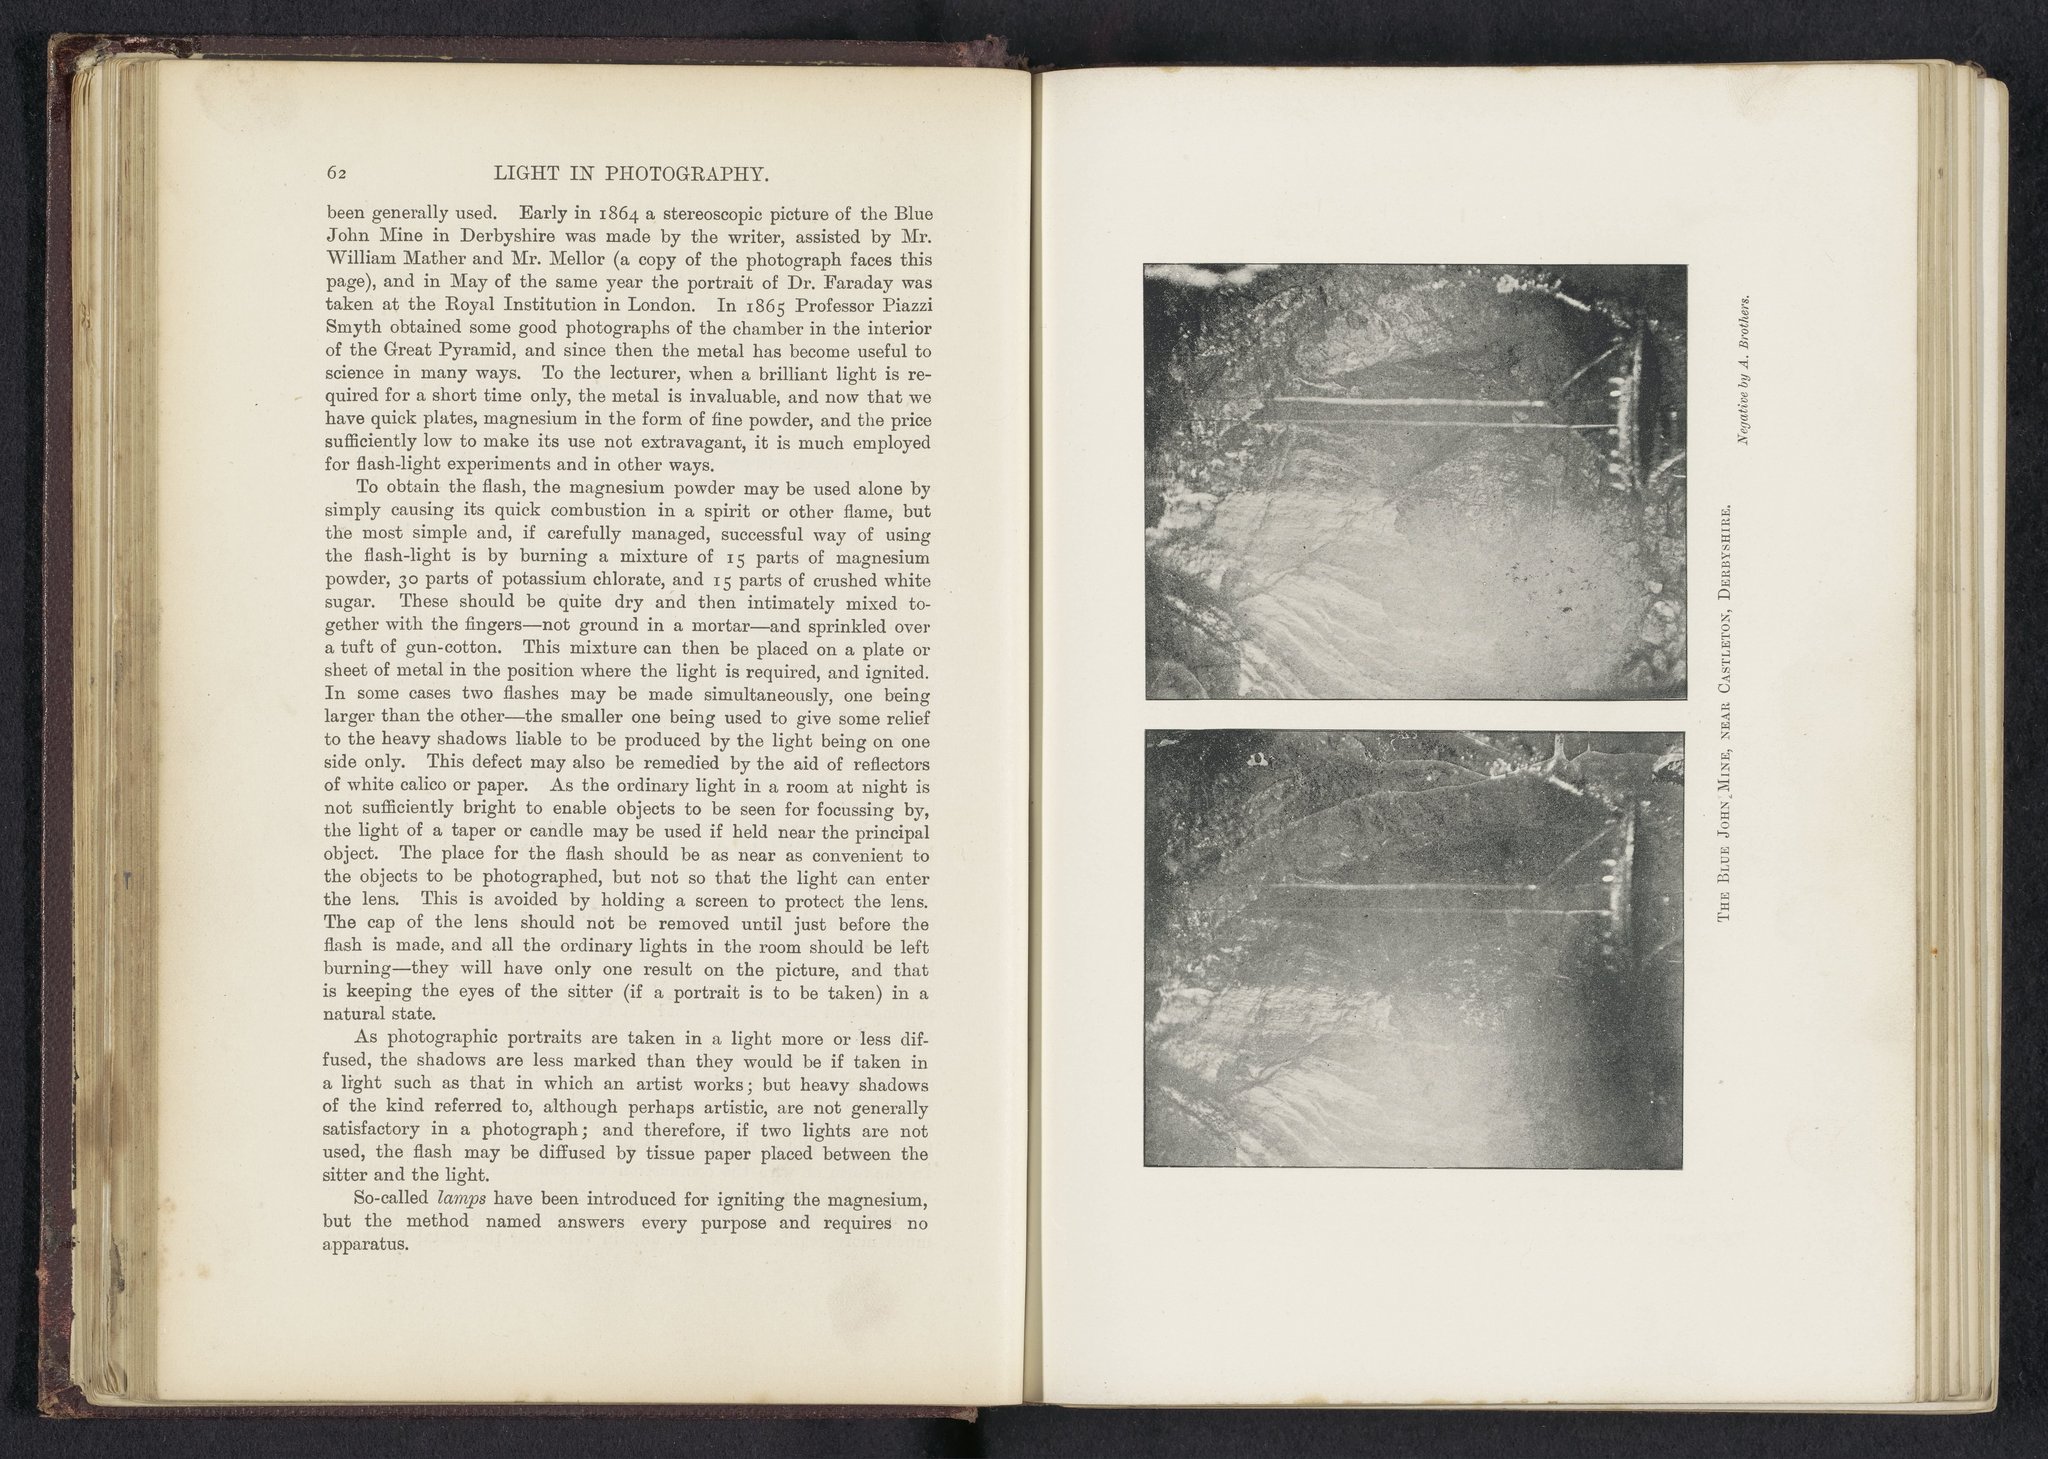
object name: photomechanical print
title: The Blue John Mine, near Castleton, Derbyshire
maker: Anonymous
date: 1889-1899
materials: paper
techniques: autotype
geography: blue john cavern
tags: cave, grotto